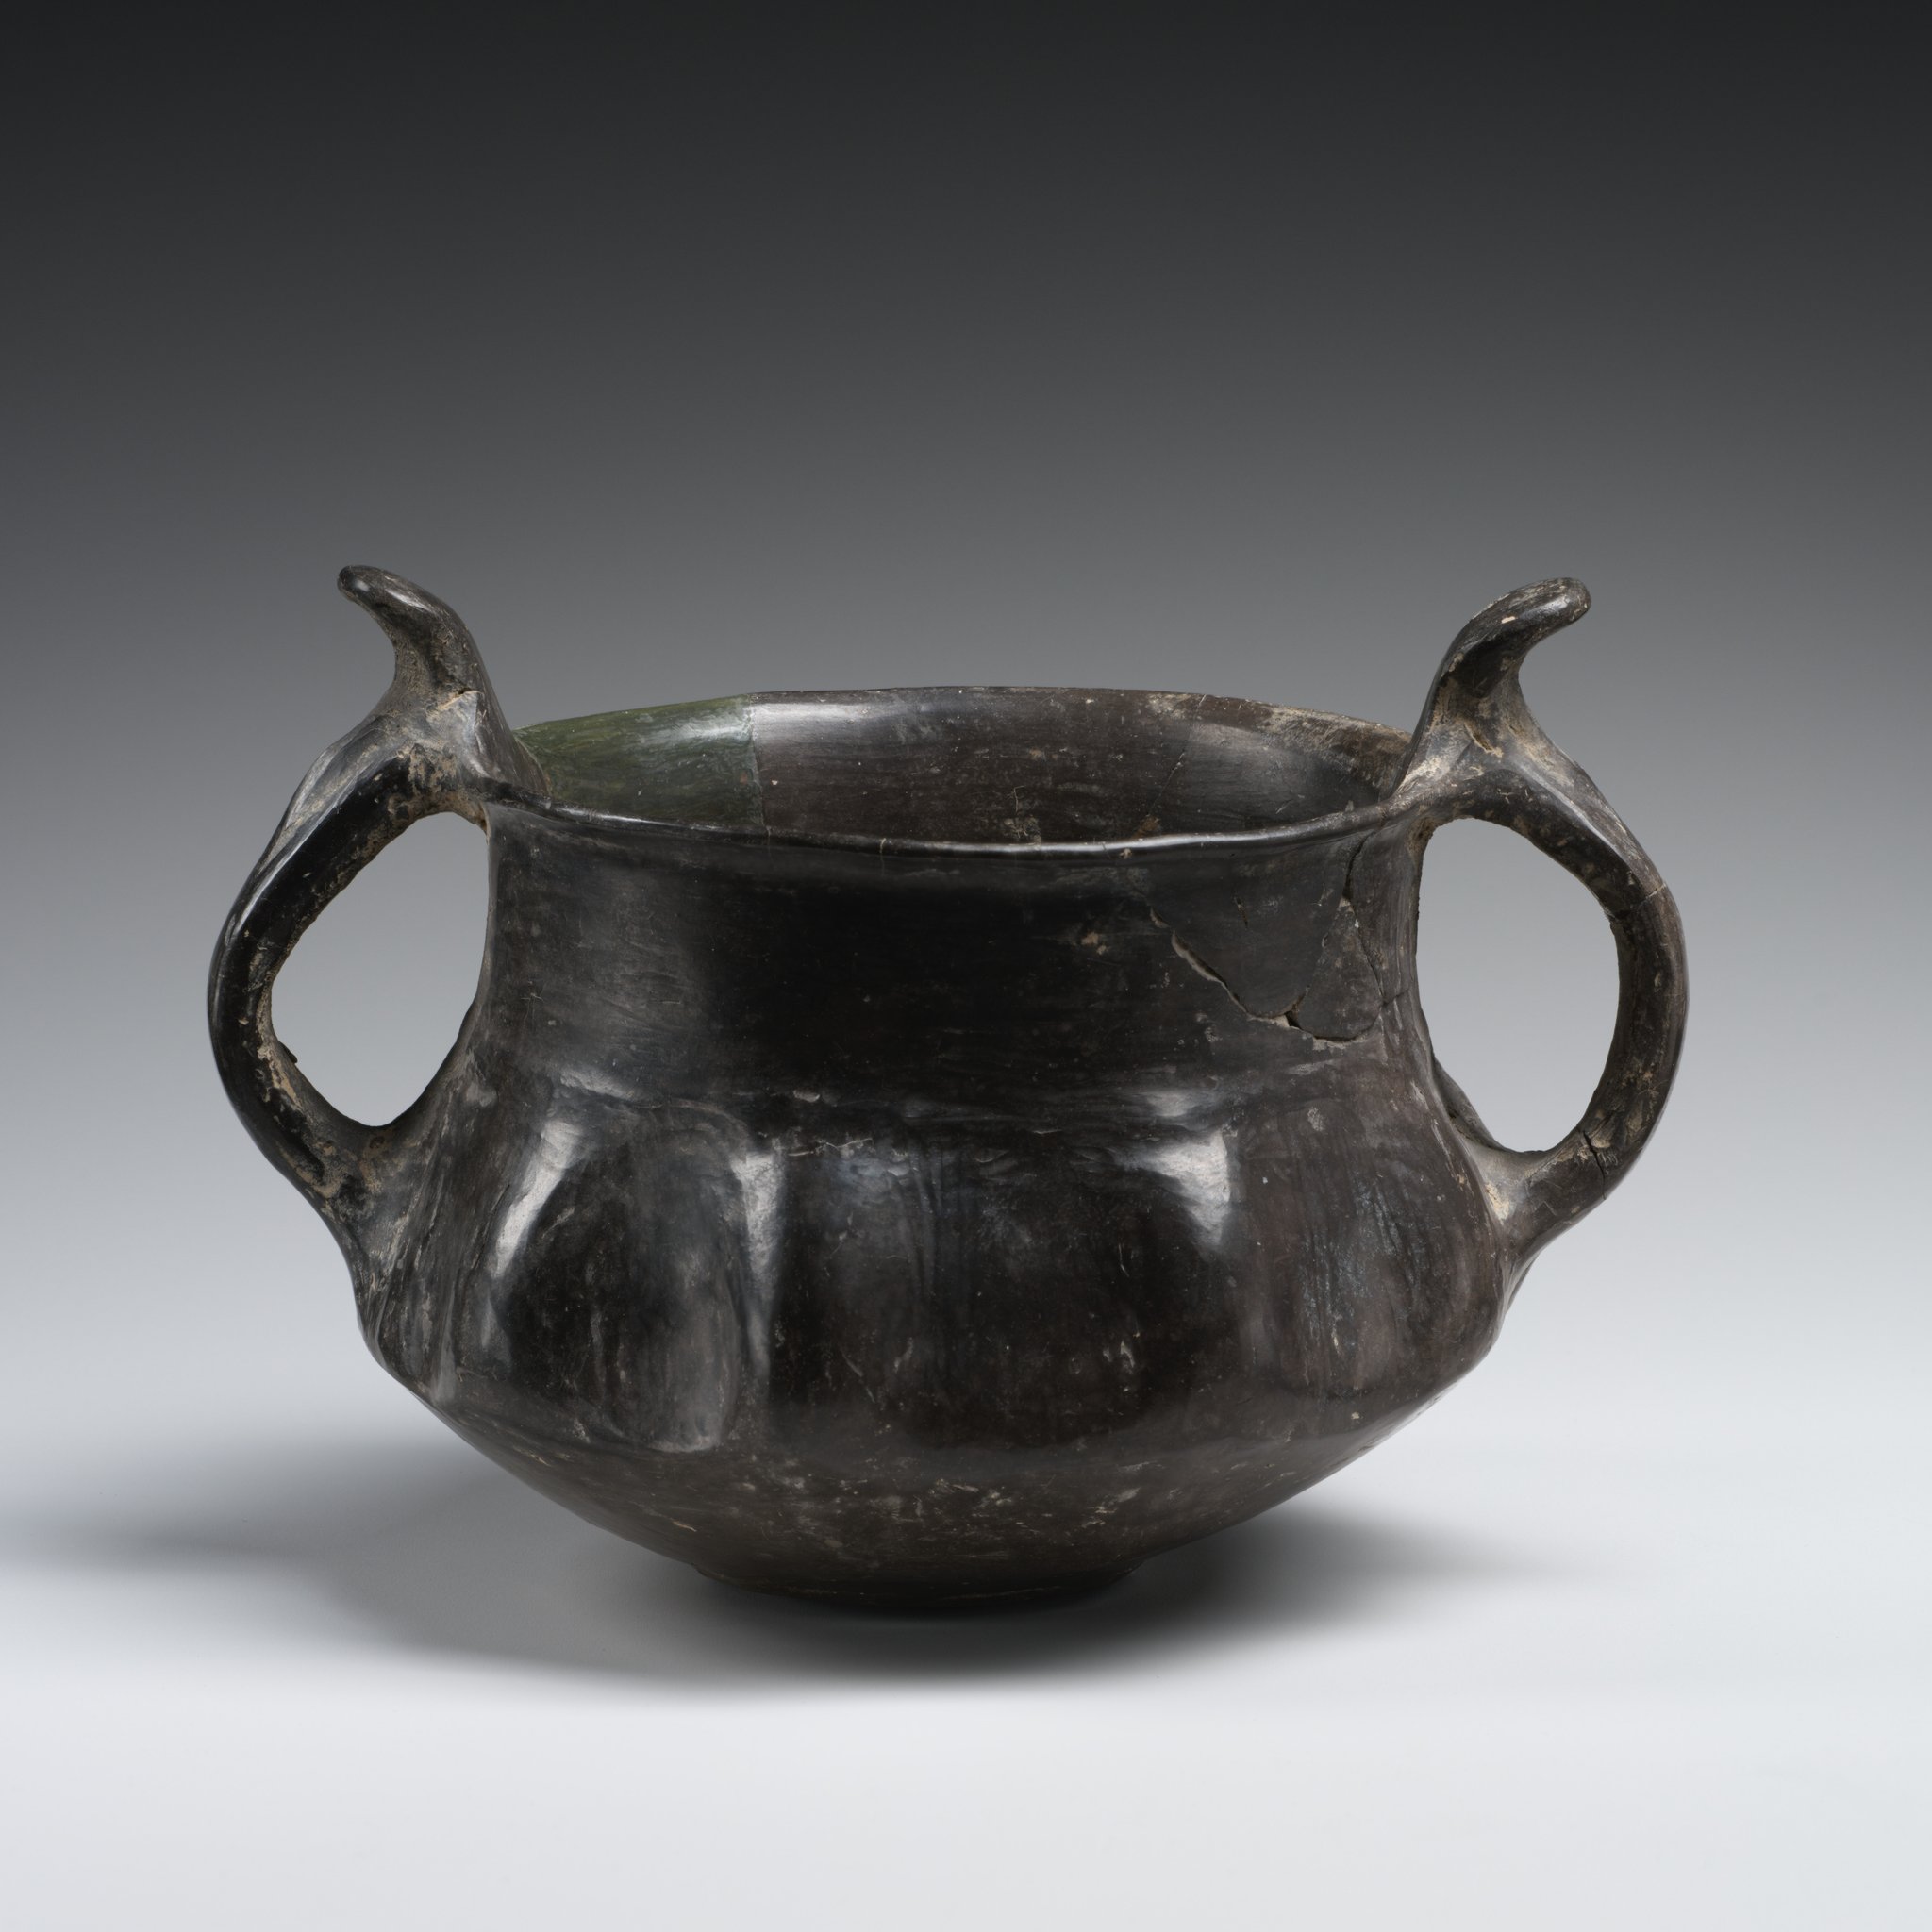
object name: bowl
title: Fluted bowl with two handles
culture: iranian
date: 900-801 BCE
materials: ceramic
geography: iran